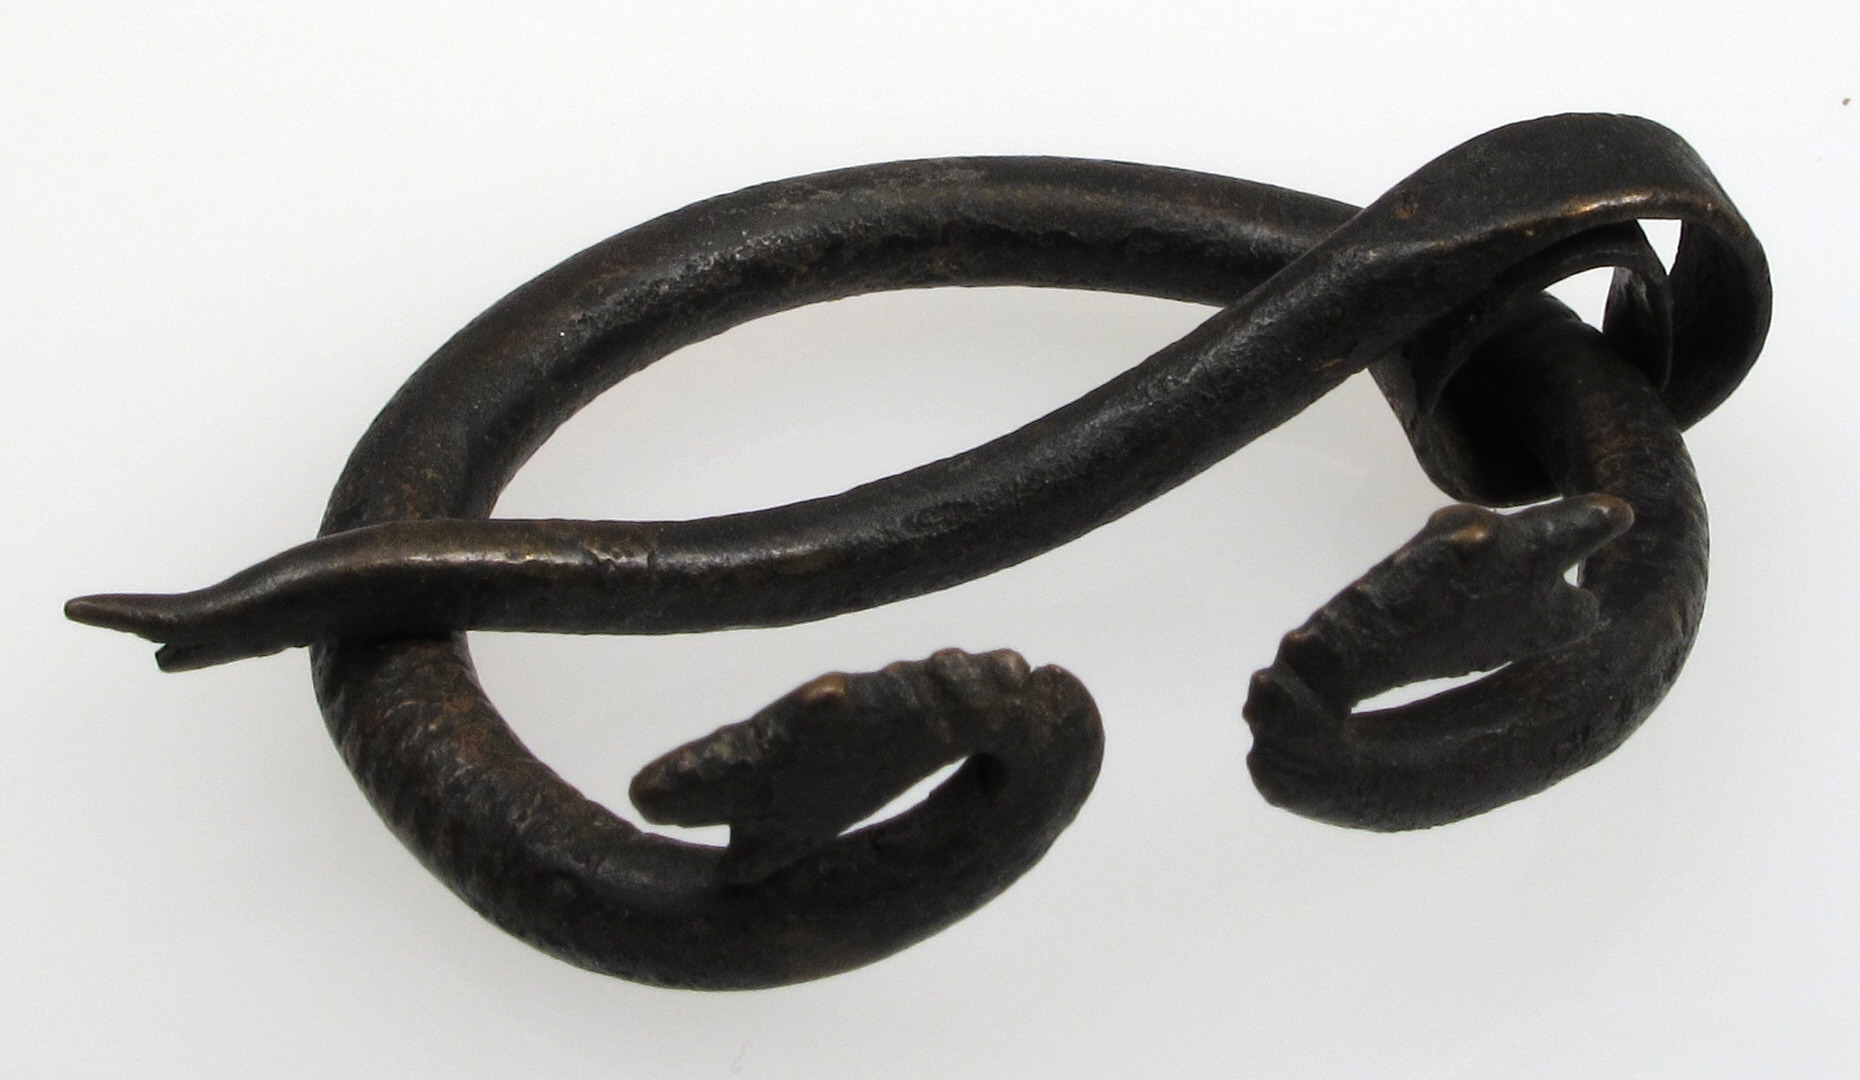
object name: brooch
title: Penannular Brooch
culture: scandinavian or baltic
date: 901-1100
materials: copper alloy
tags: serpents